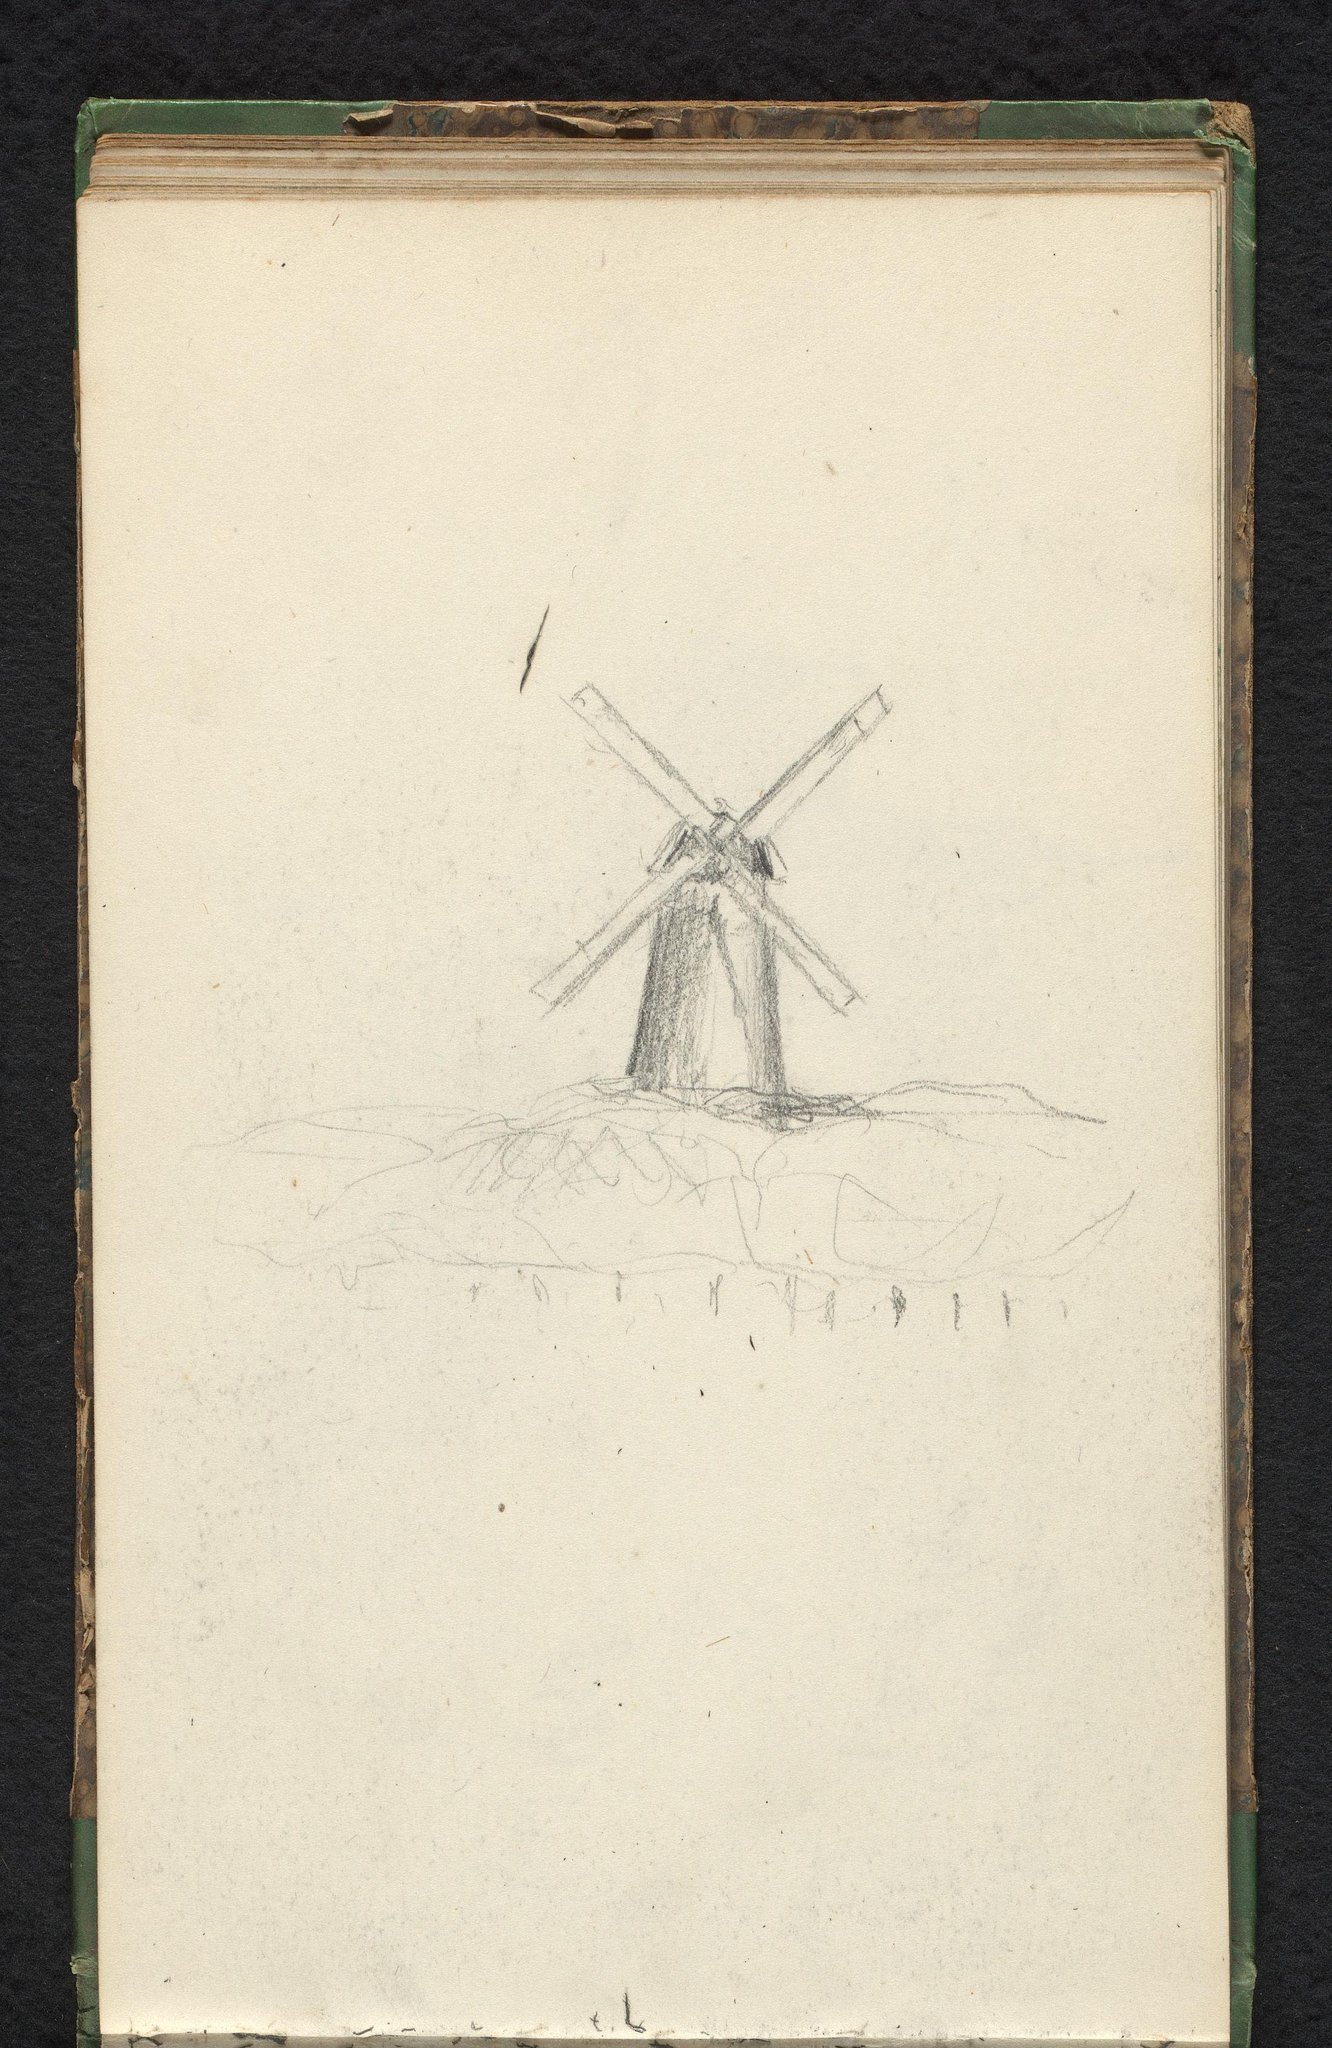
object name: sketchbook leaf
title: Molen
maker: jan bedijs tom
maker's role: draughtsman, painter, print maker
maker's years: 1813-1894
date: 1823-1894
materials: paper, pencil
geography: the hague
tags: windmill in landscape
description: Pagina 18 verso uit een schetsboek met 61 bladen.